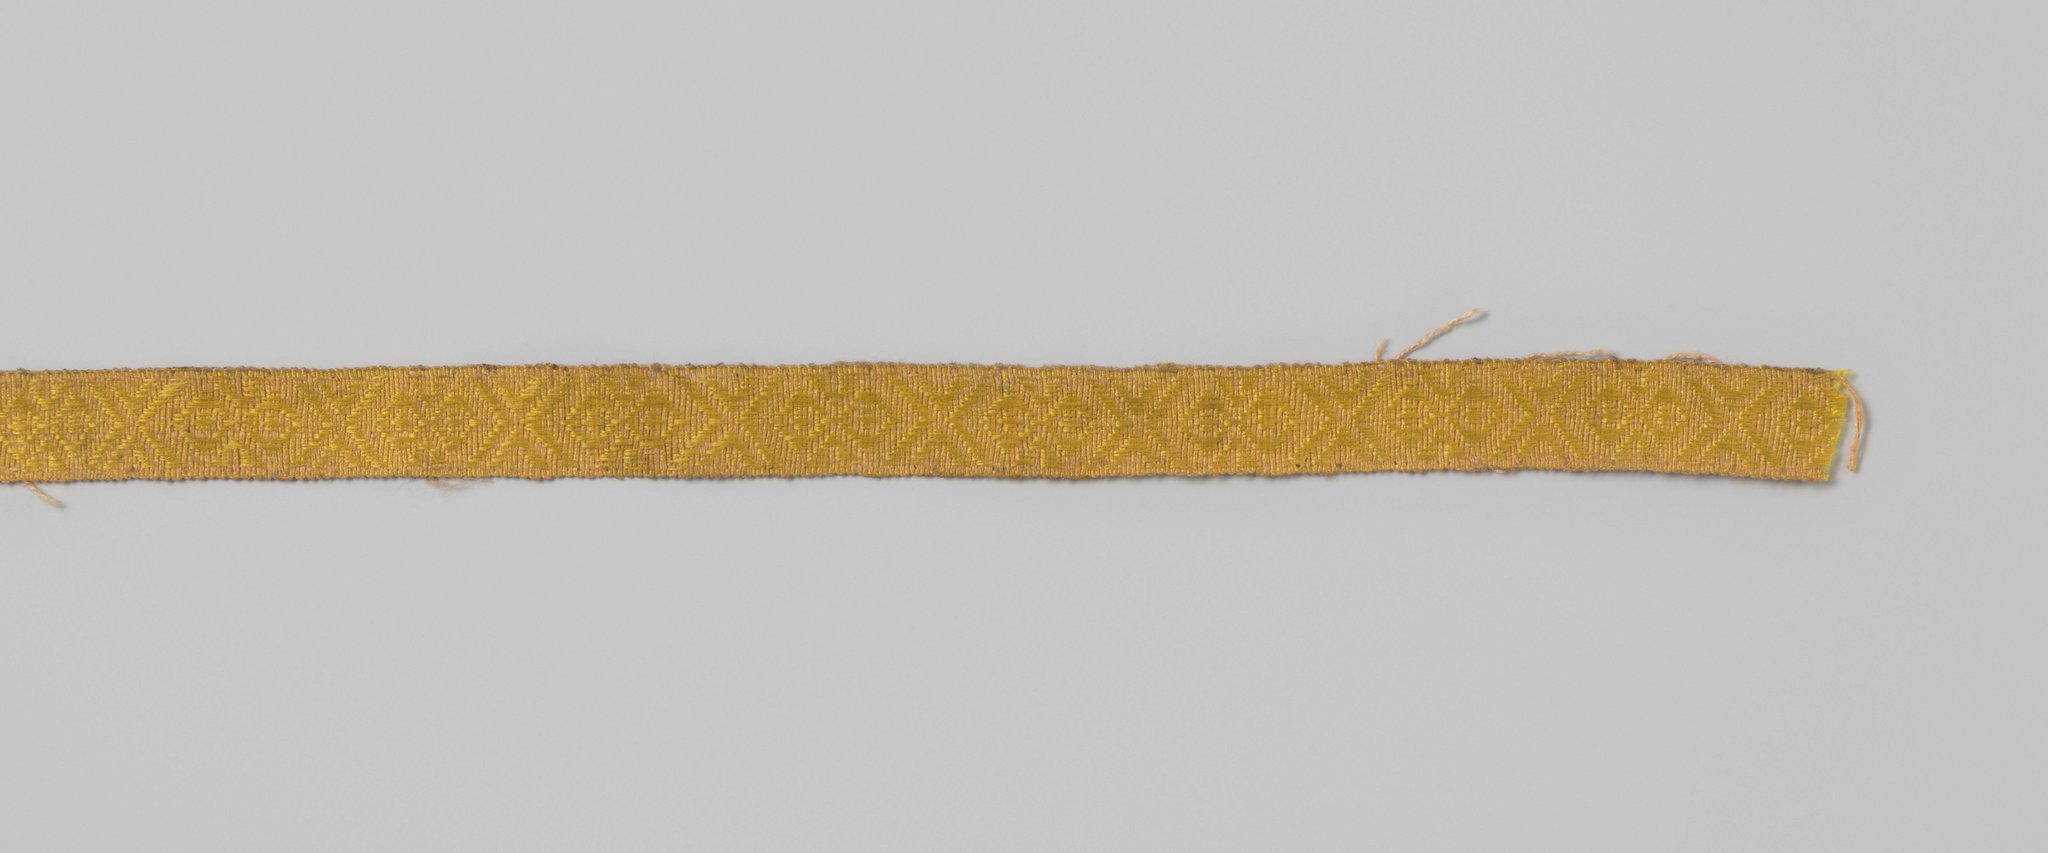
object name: braid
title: Passement van linnen en gele zijde in ruitpatroon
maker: Anonymous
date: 1700-1899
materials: linen, silk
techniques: weave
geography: europe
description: Passement van linnen en gele zijde in een patroon van ruiten in ruiten. BK-NM-12186-20-A, BK-NM-12186-20-B en BK-NM-12186-21 hebben eenzelfde patroon.